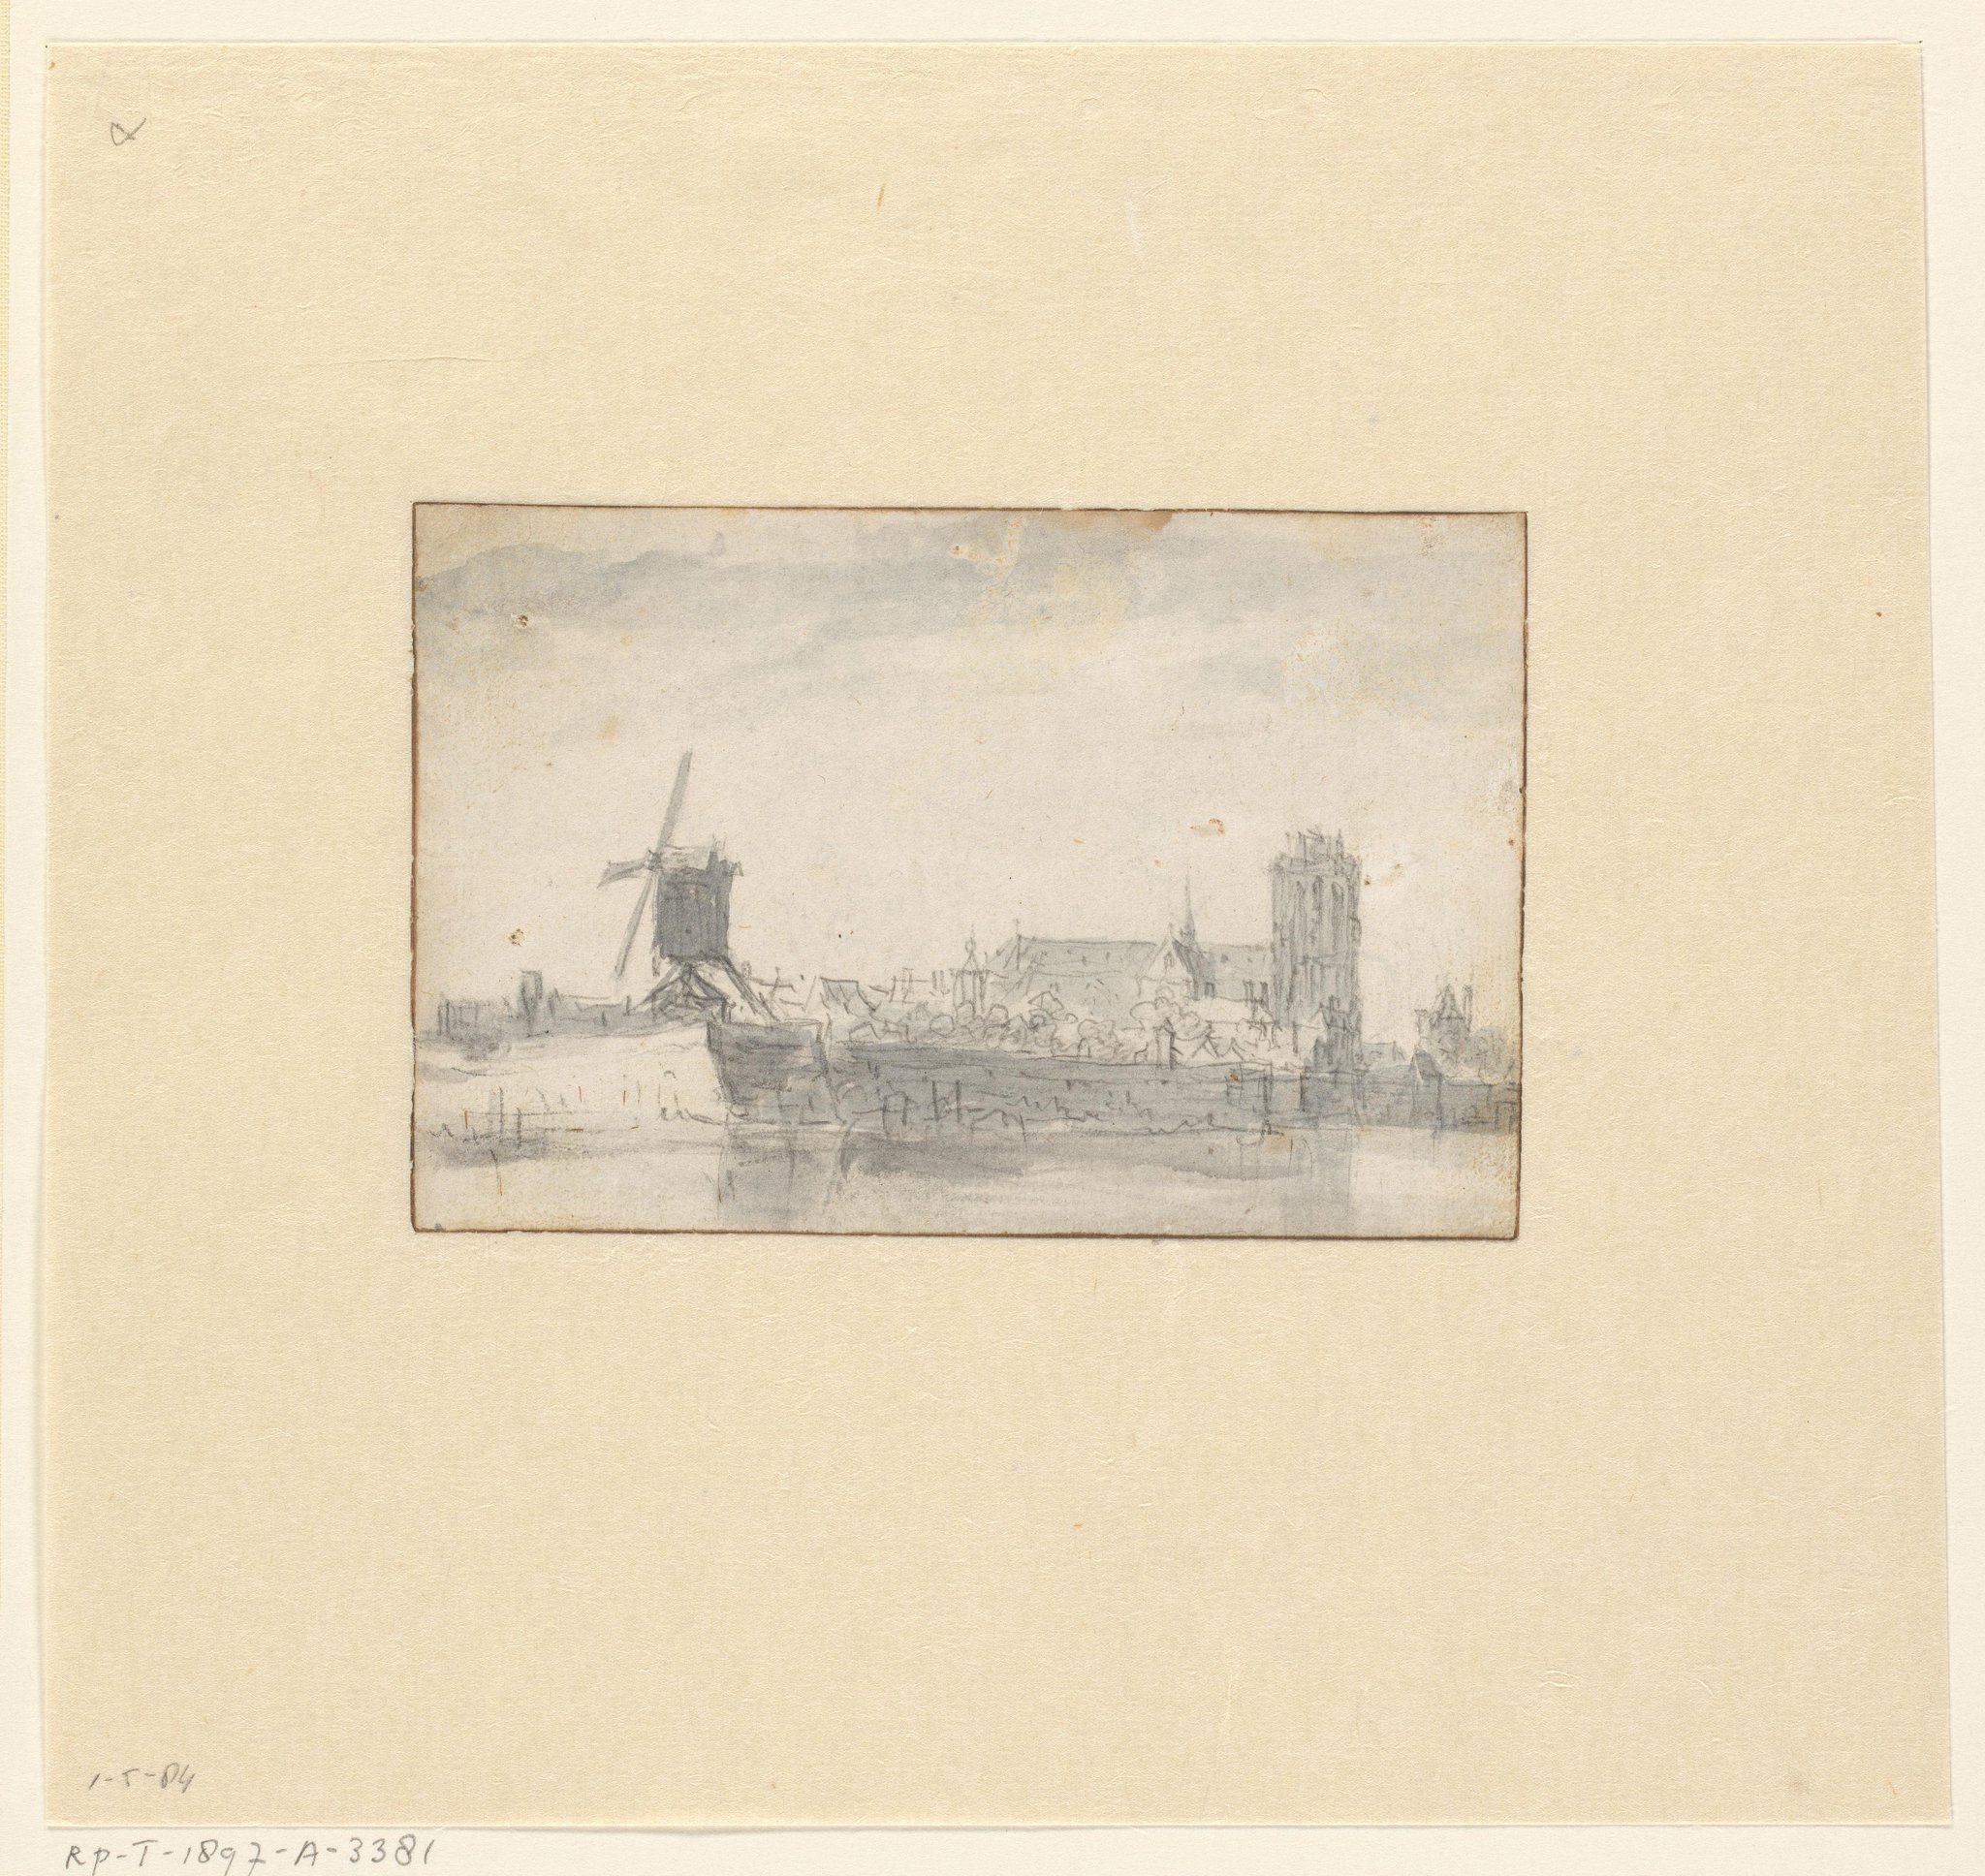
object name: drawing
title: Gezicht op Dordrecht vanaf het water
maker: jan van goyen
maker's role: draughtsman, painter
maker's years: 1596-1656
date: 1647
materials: chalk, paper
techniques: brush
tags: quay, dordrecht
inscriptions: date